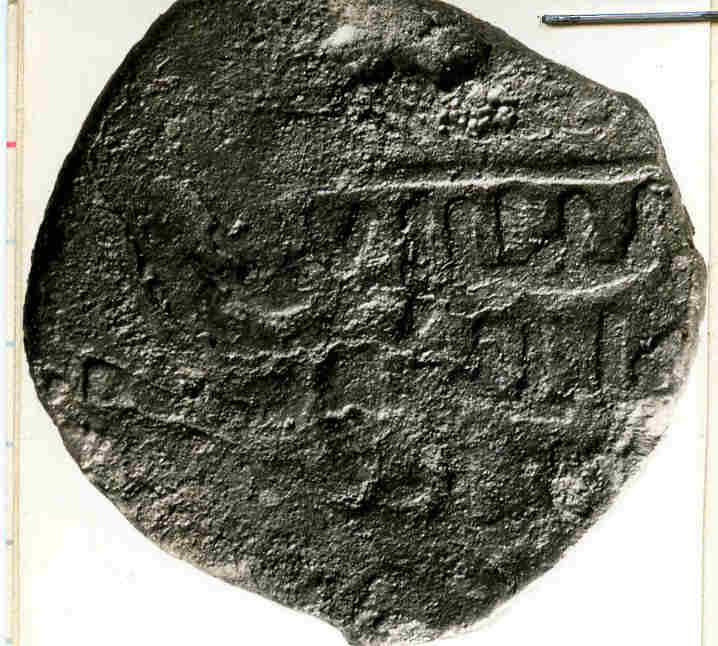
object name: coin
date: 1267-1300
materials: copper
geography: iran